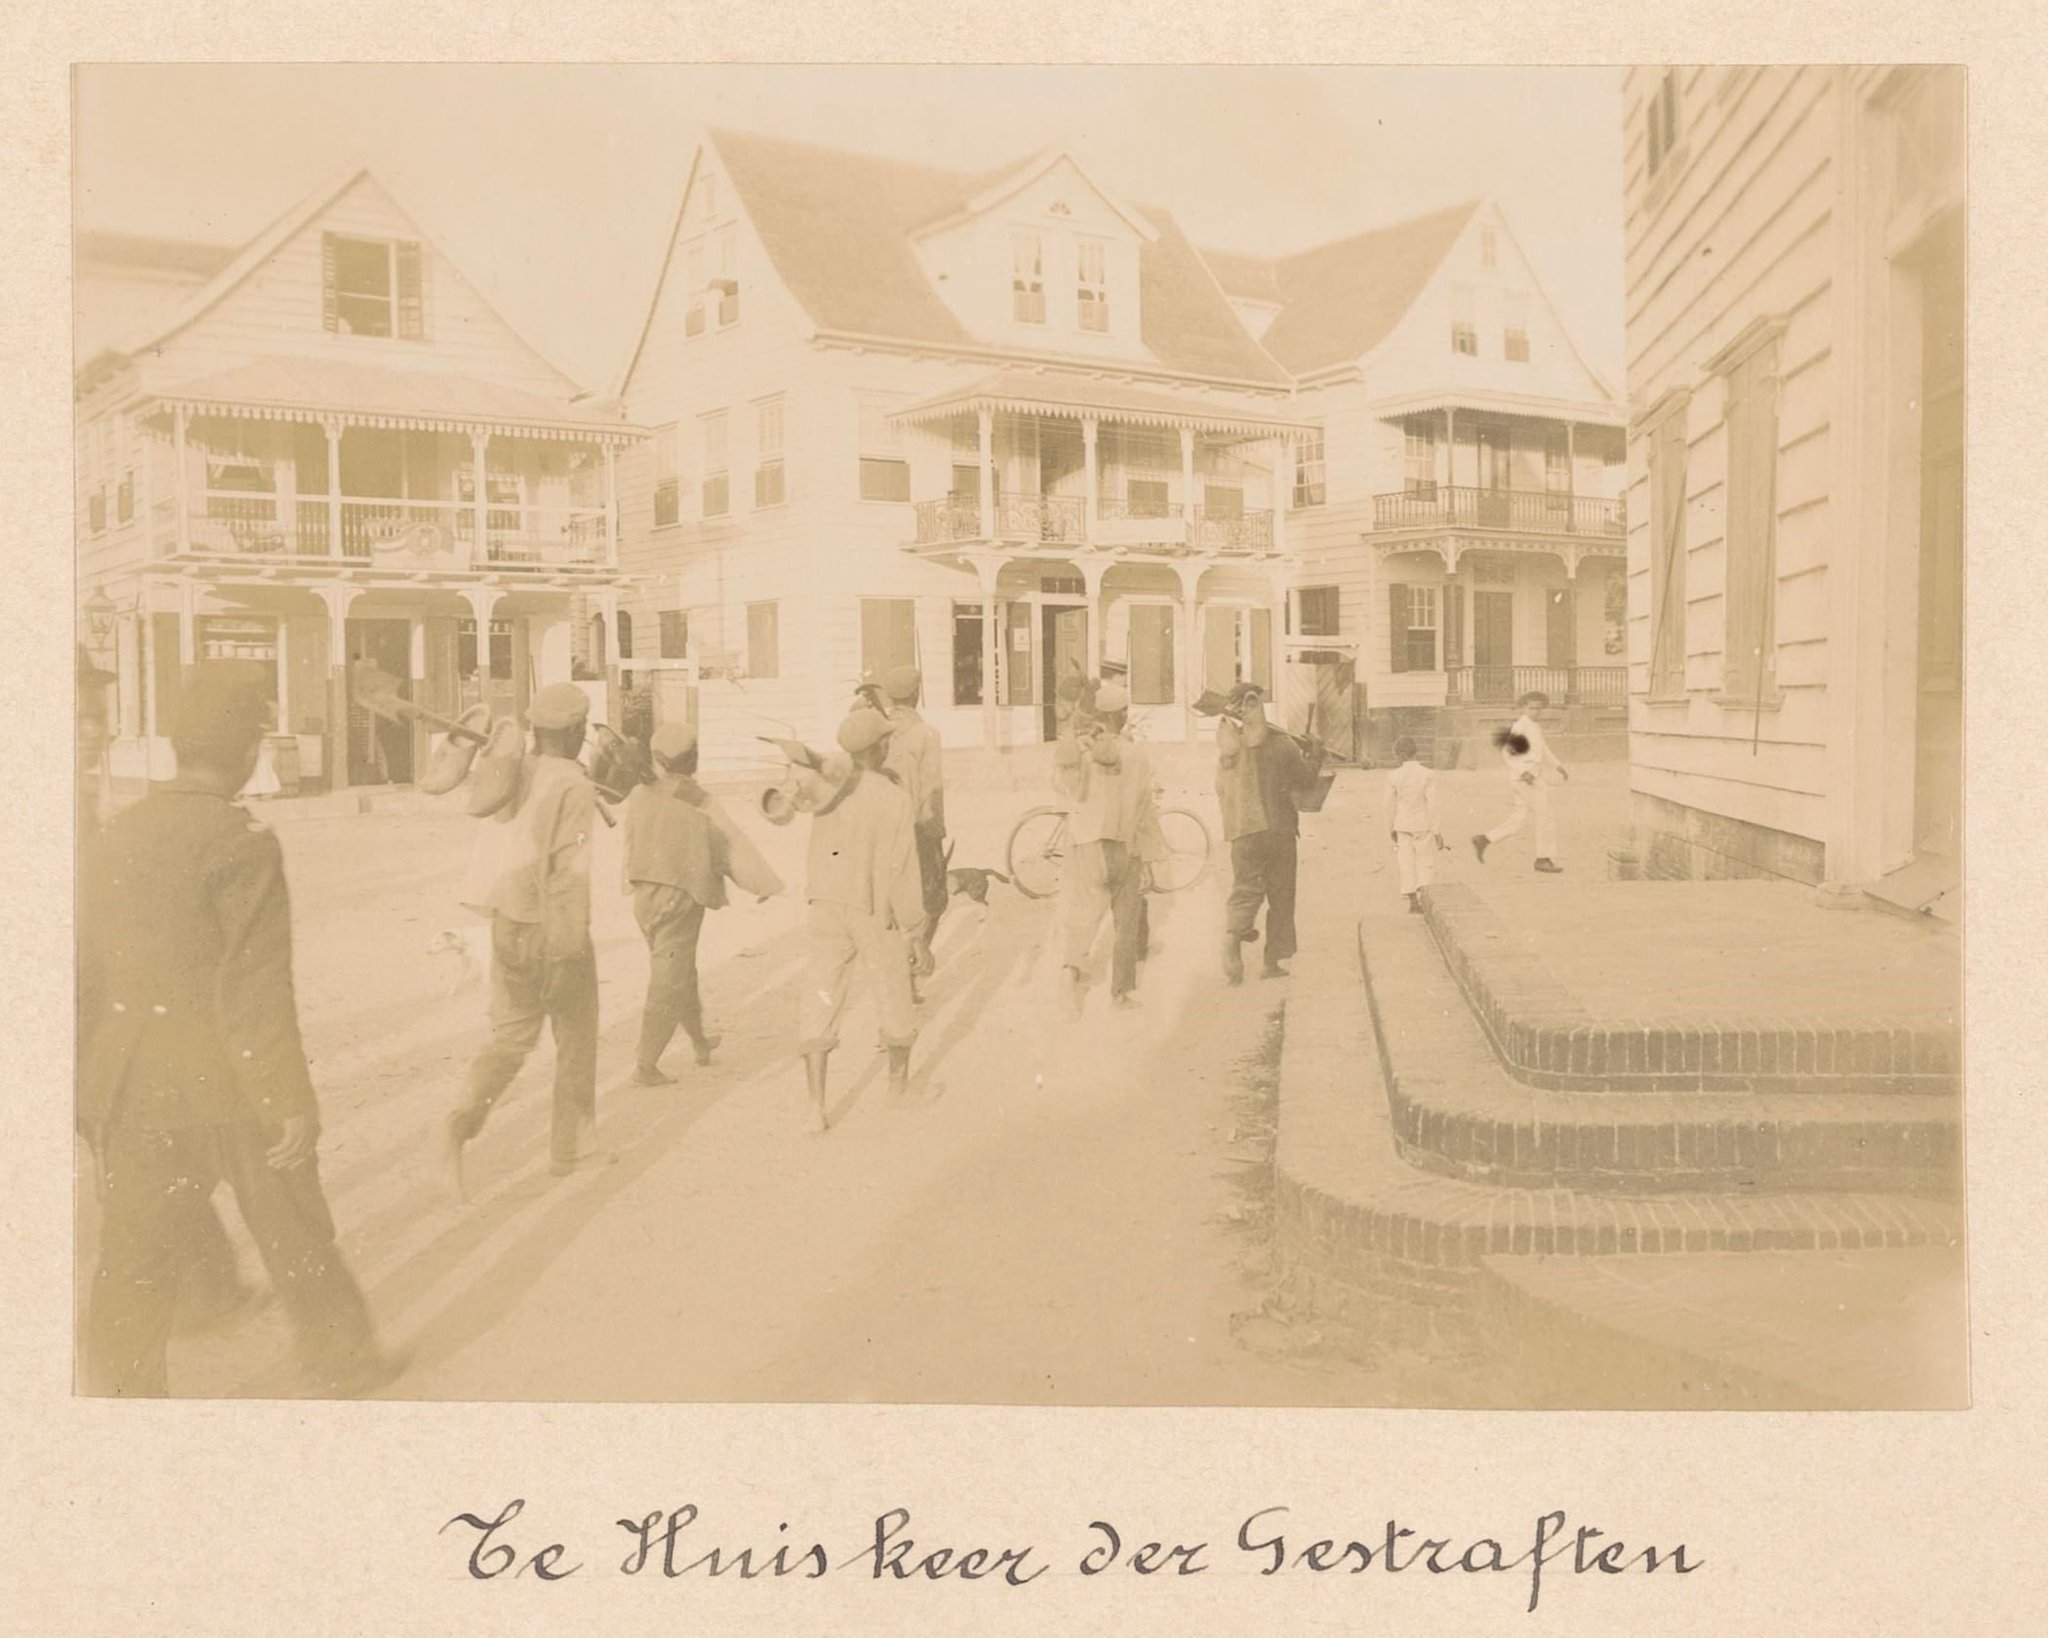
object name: photograph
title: De Huiskeer der Gestraften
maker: eugen klein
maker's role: fotograaf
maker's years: 1869-1927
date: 1900-1905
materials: cardboard, photographic support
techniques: gelatin silver print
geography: paramaribo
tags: paramaribo (stad)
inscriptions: inscription: ‘Paramaribo / De Huiskeer der Gestraften’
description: Te werk gestelde gevangen keren terug naar de gevangenis, lopend door een straat te Paramaribo. Onderdeel van een groep van 44 foto's van Paramaribo, Suriname en Curaçao, ca. 1900-1905, opgeplakt op kartons en voorzien van opschriften.